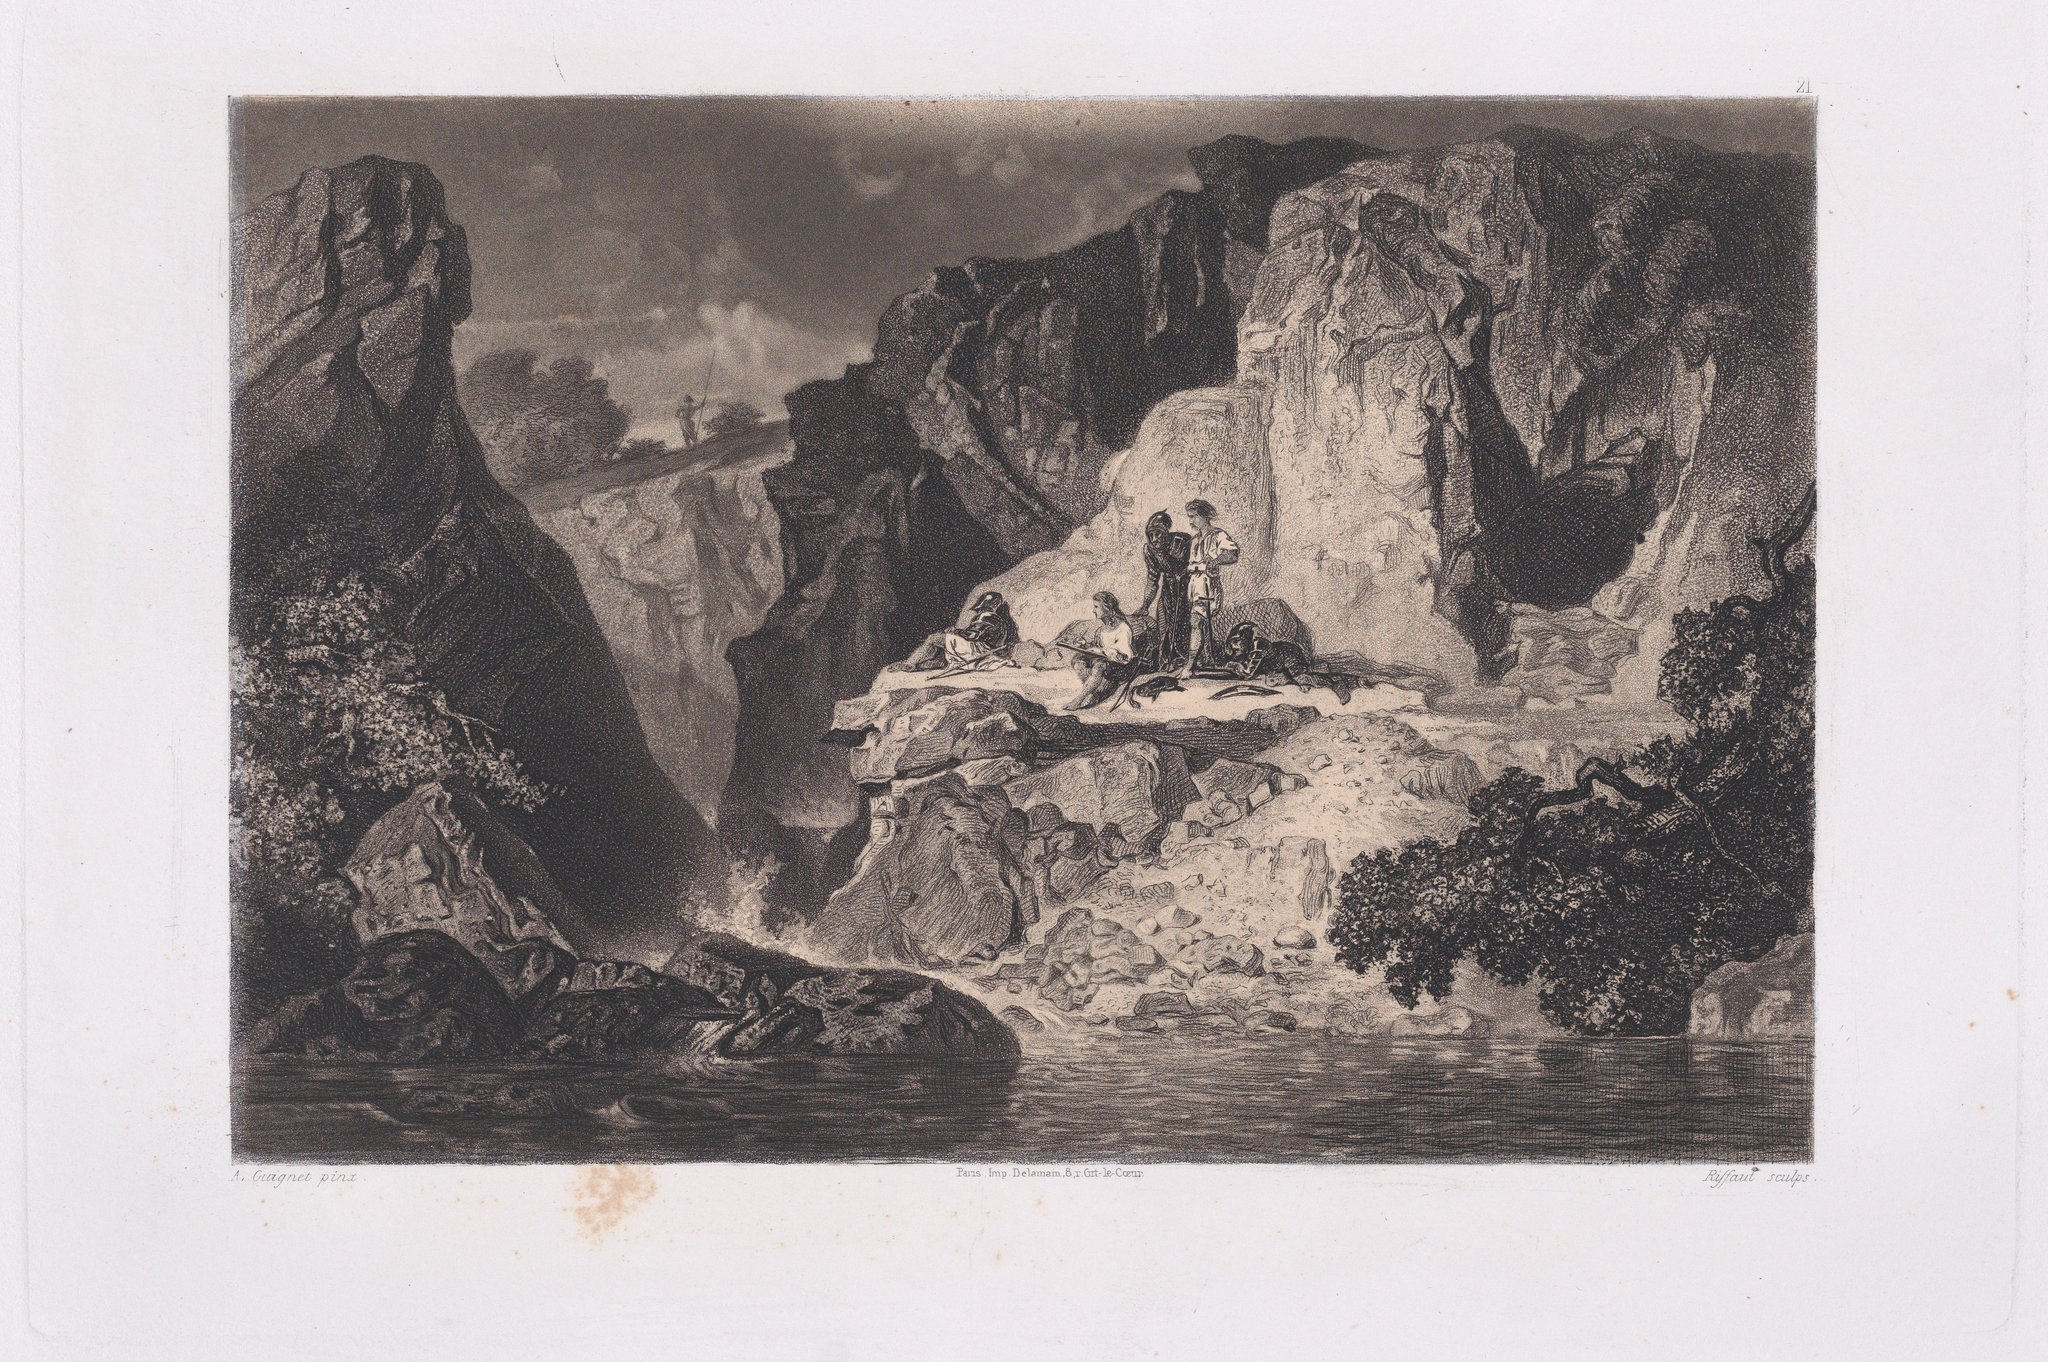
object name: print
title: Salvator Rosa among the Brigands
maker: adolphe pierre riffaut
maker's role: etcher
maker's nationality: french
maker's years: 1821-1859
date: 1844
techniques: aquatint, printmaking, etching